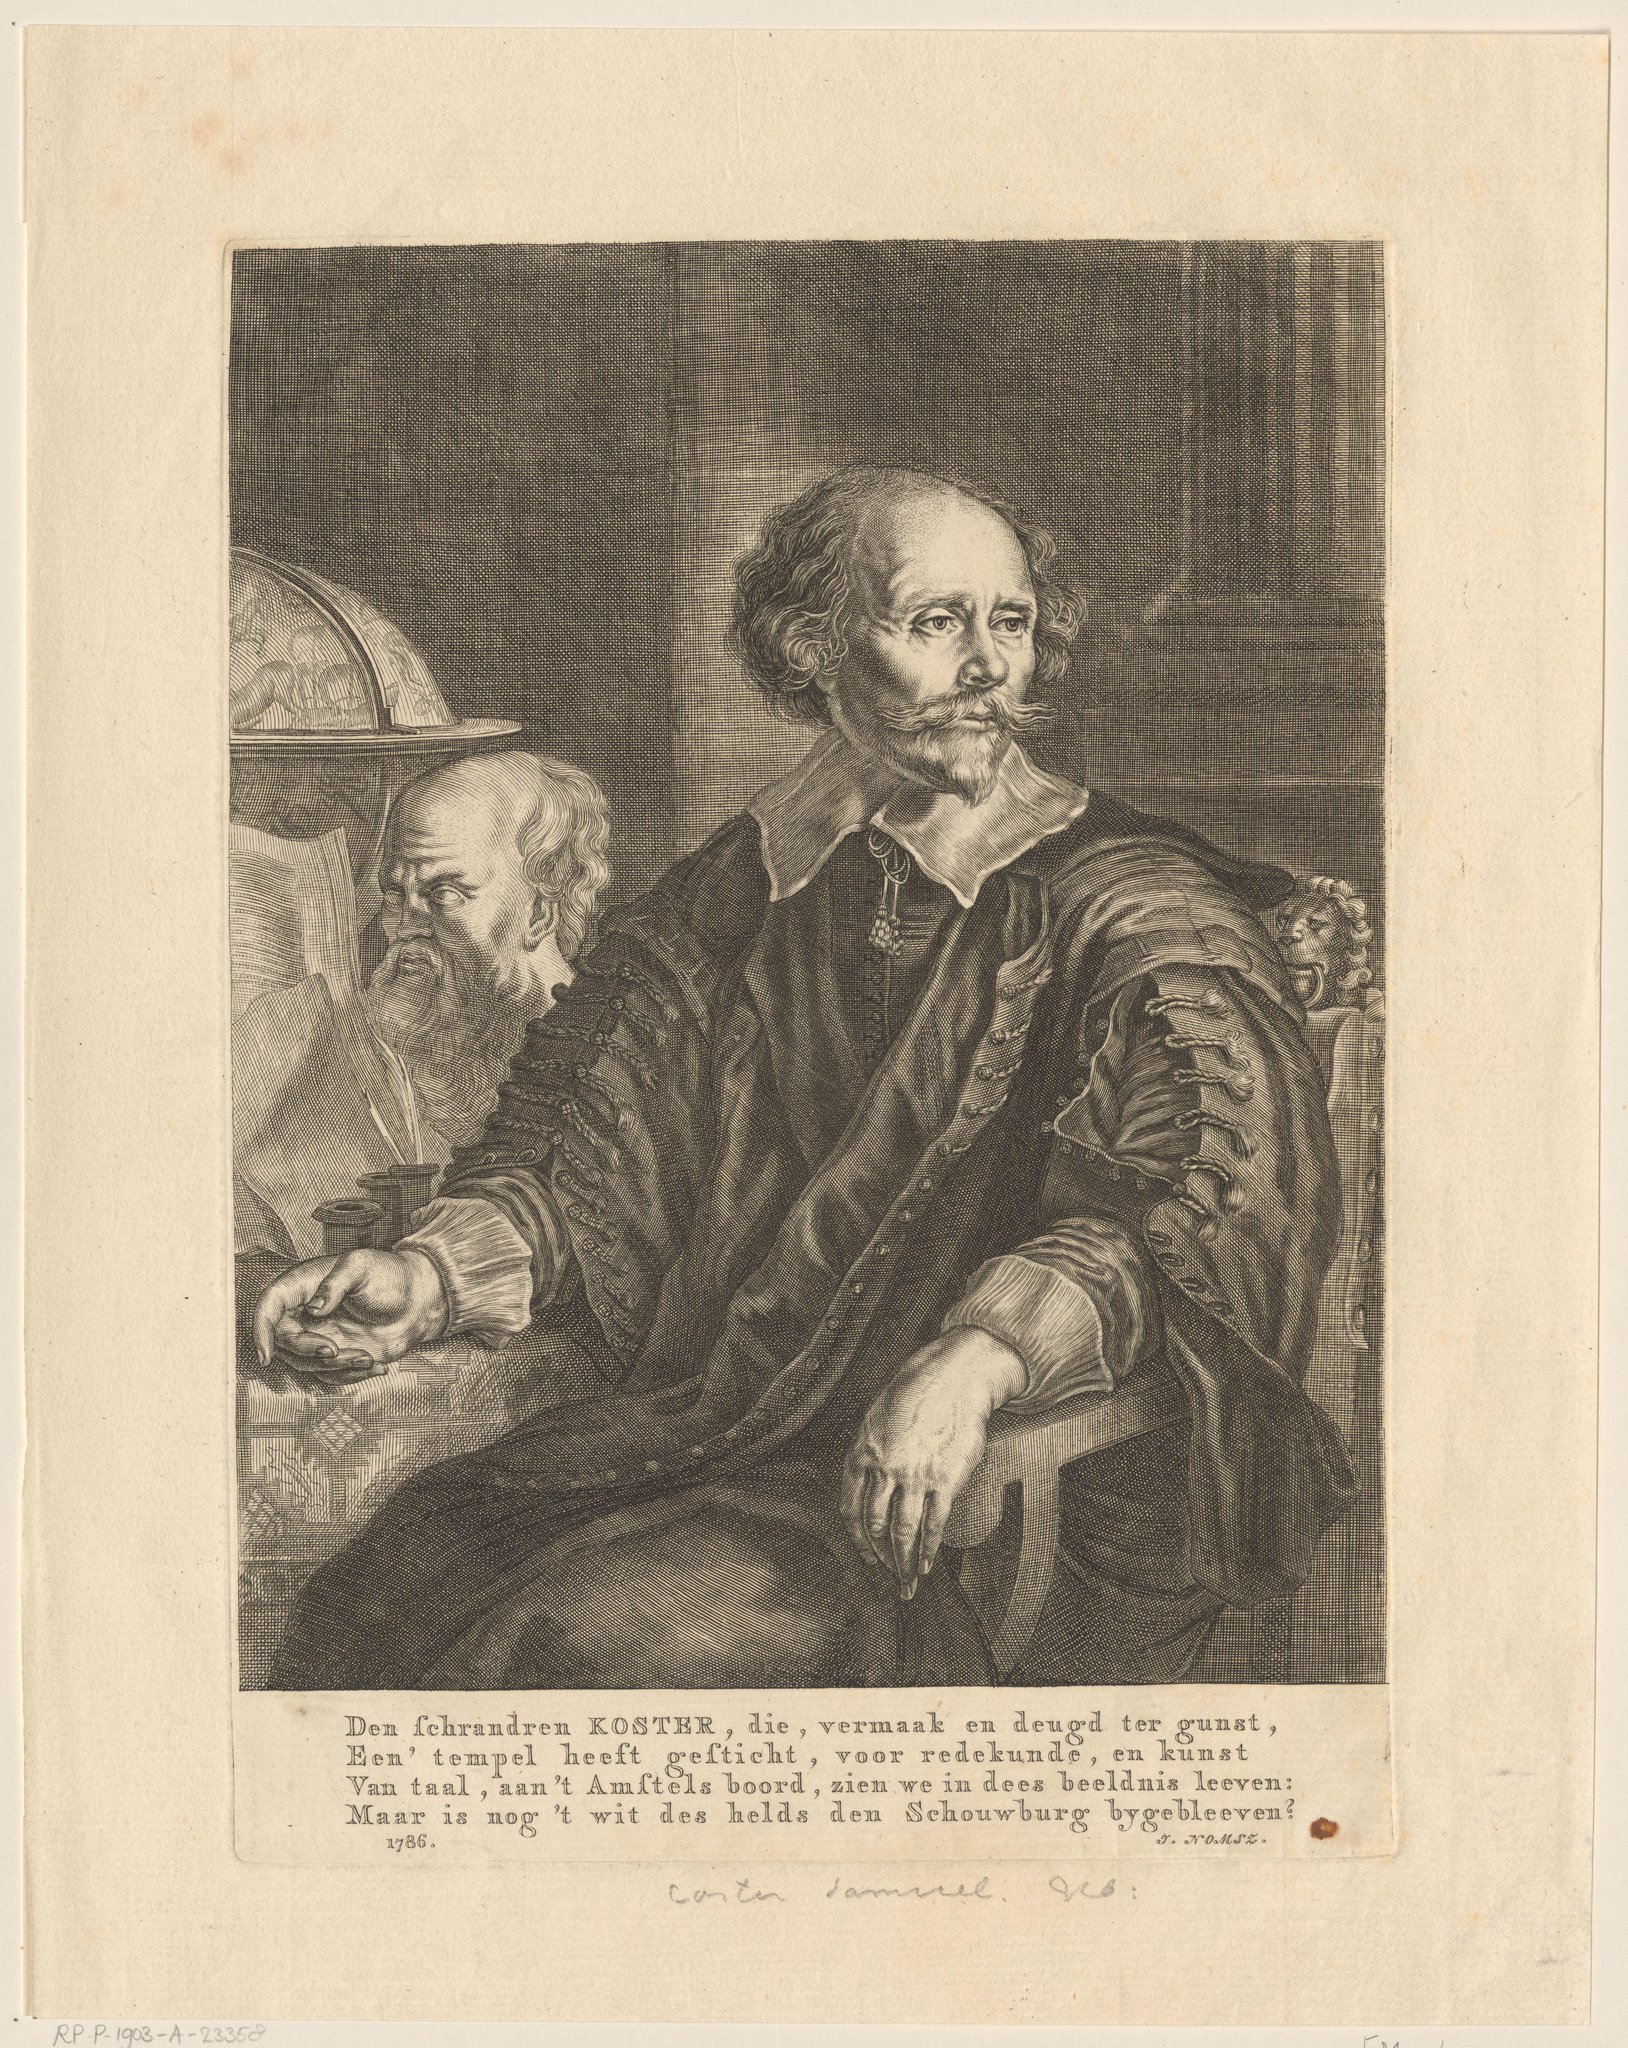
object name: print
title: Portret van Samuel Coster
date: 1786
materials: paper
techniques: engraving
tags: samuel coster, historical persons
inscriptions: collector's mark: Lugt 2228